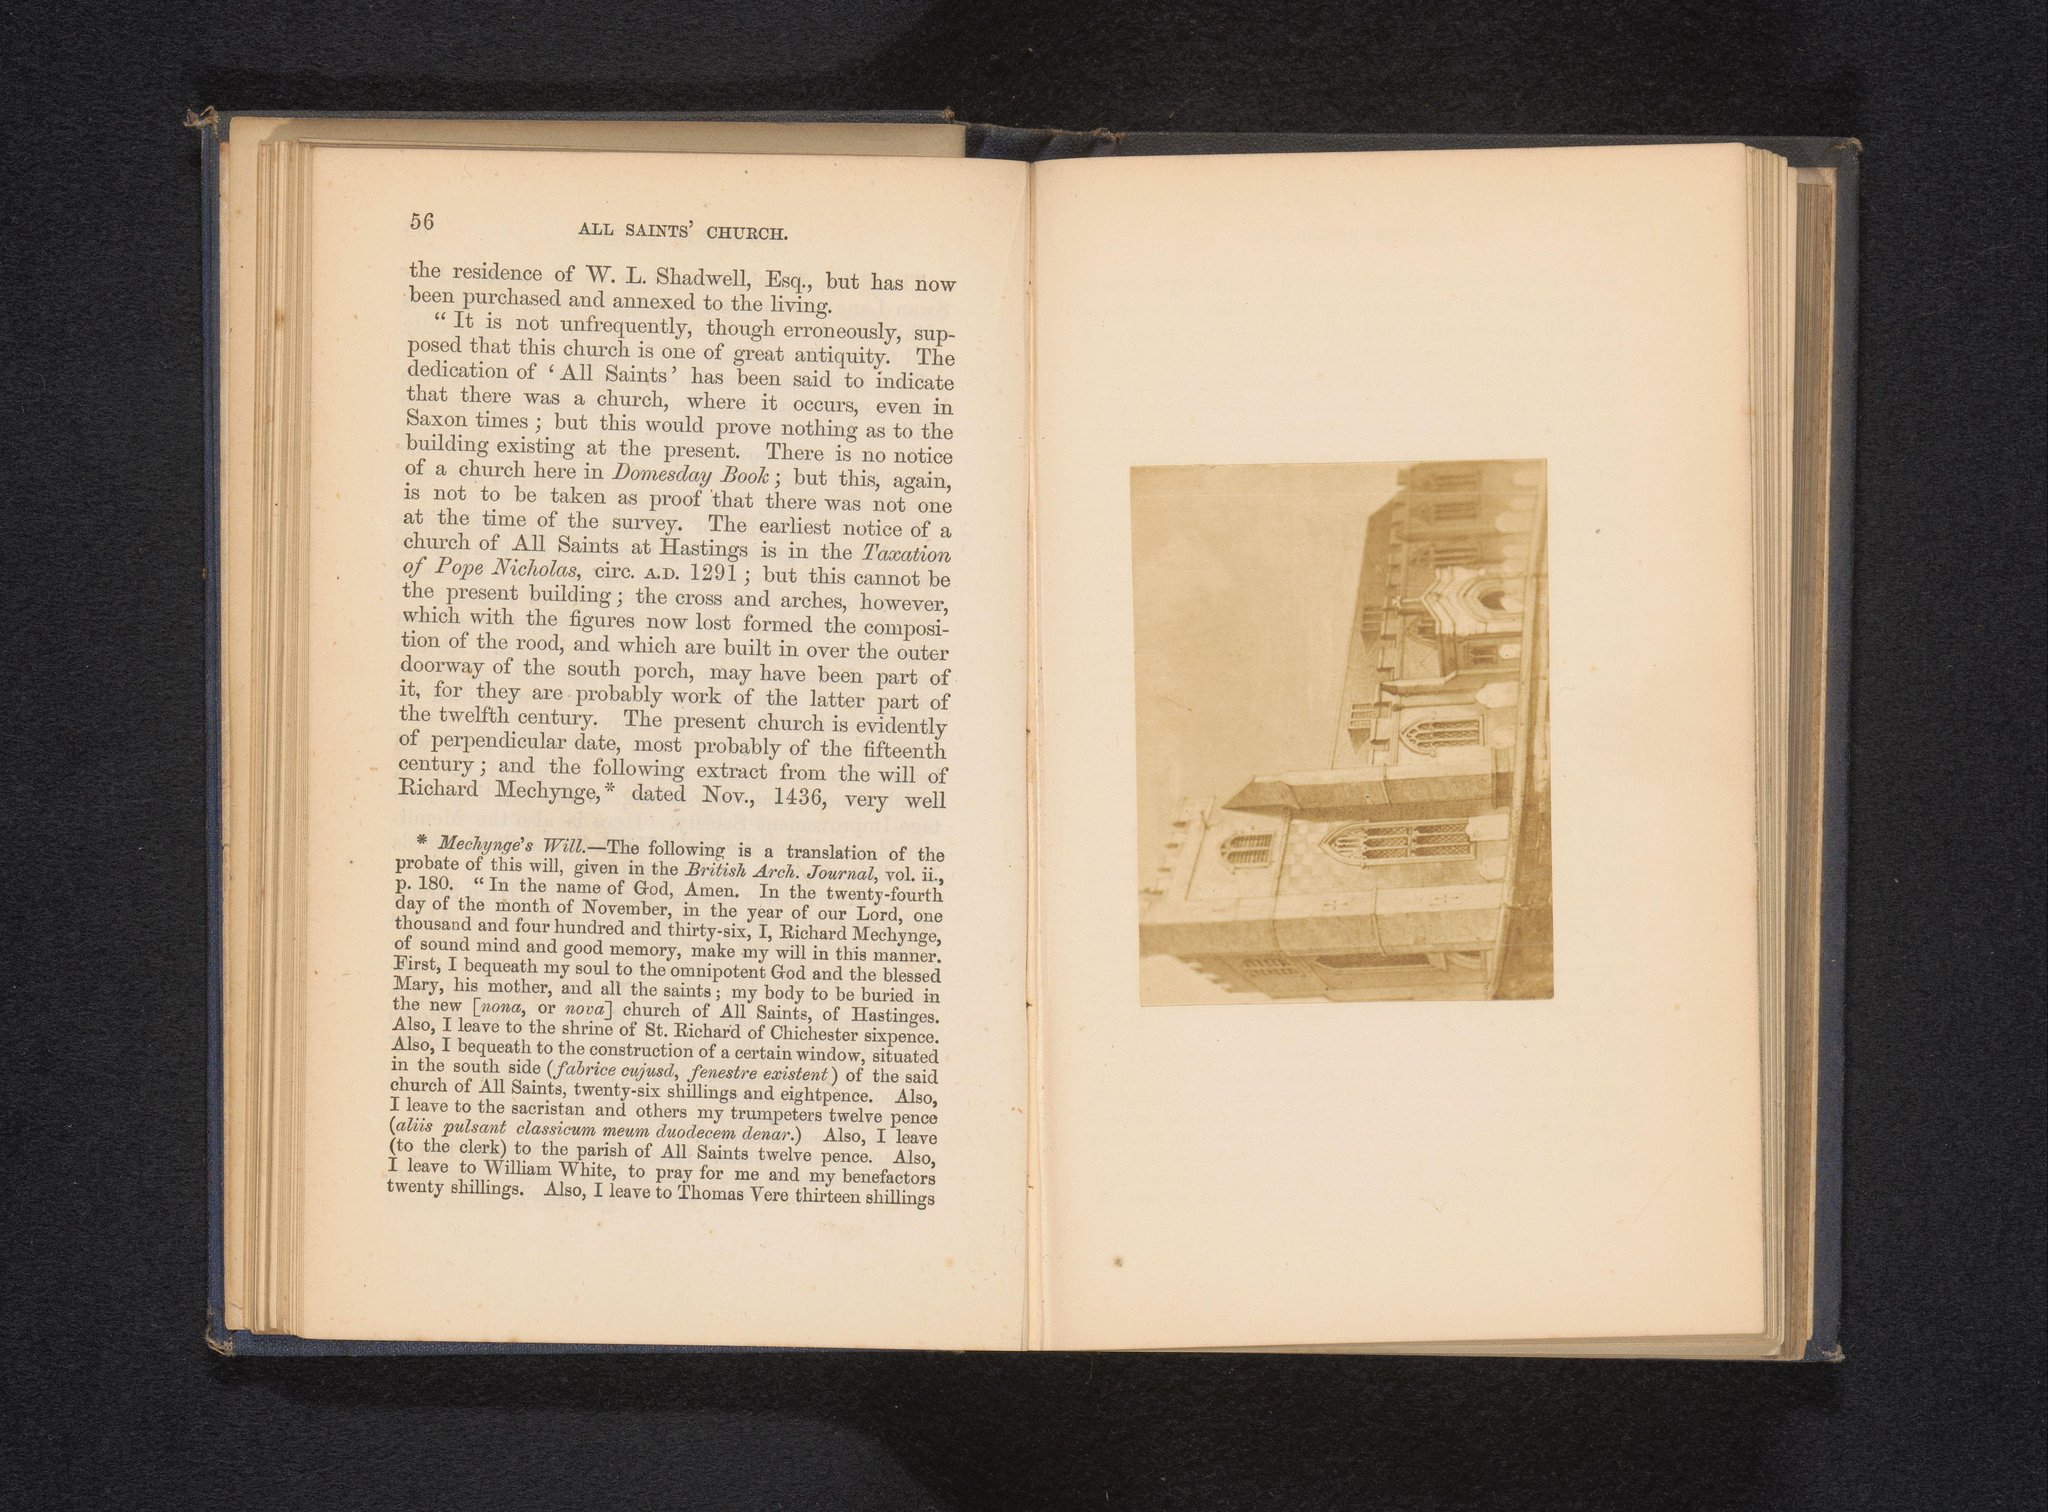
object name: photograph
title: Gezicht op de All Saints kerk te Hastings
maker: Anonymous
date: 1859-1864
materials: photographic support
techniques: albumen print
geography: hastings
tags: church (exterior)